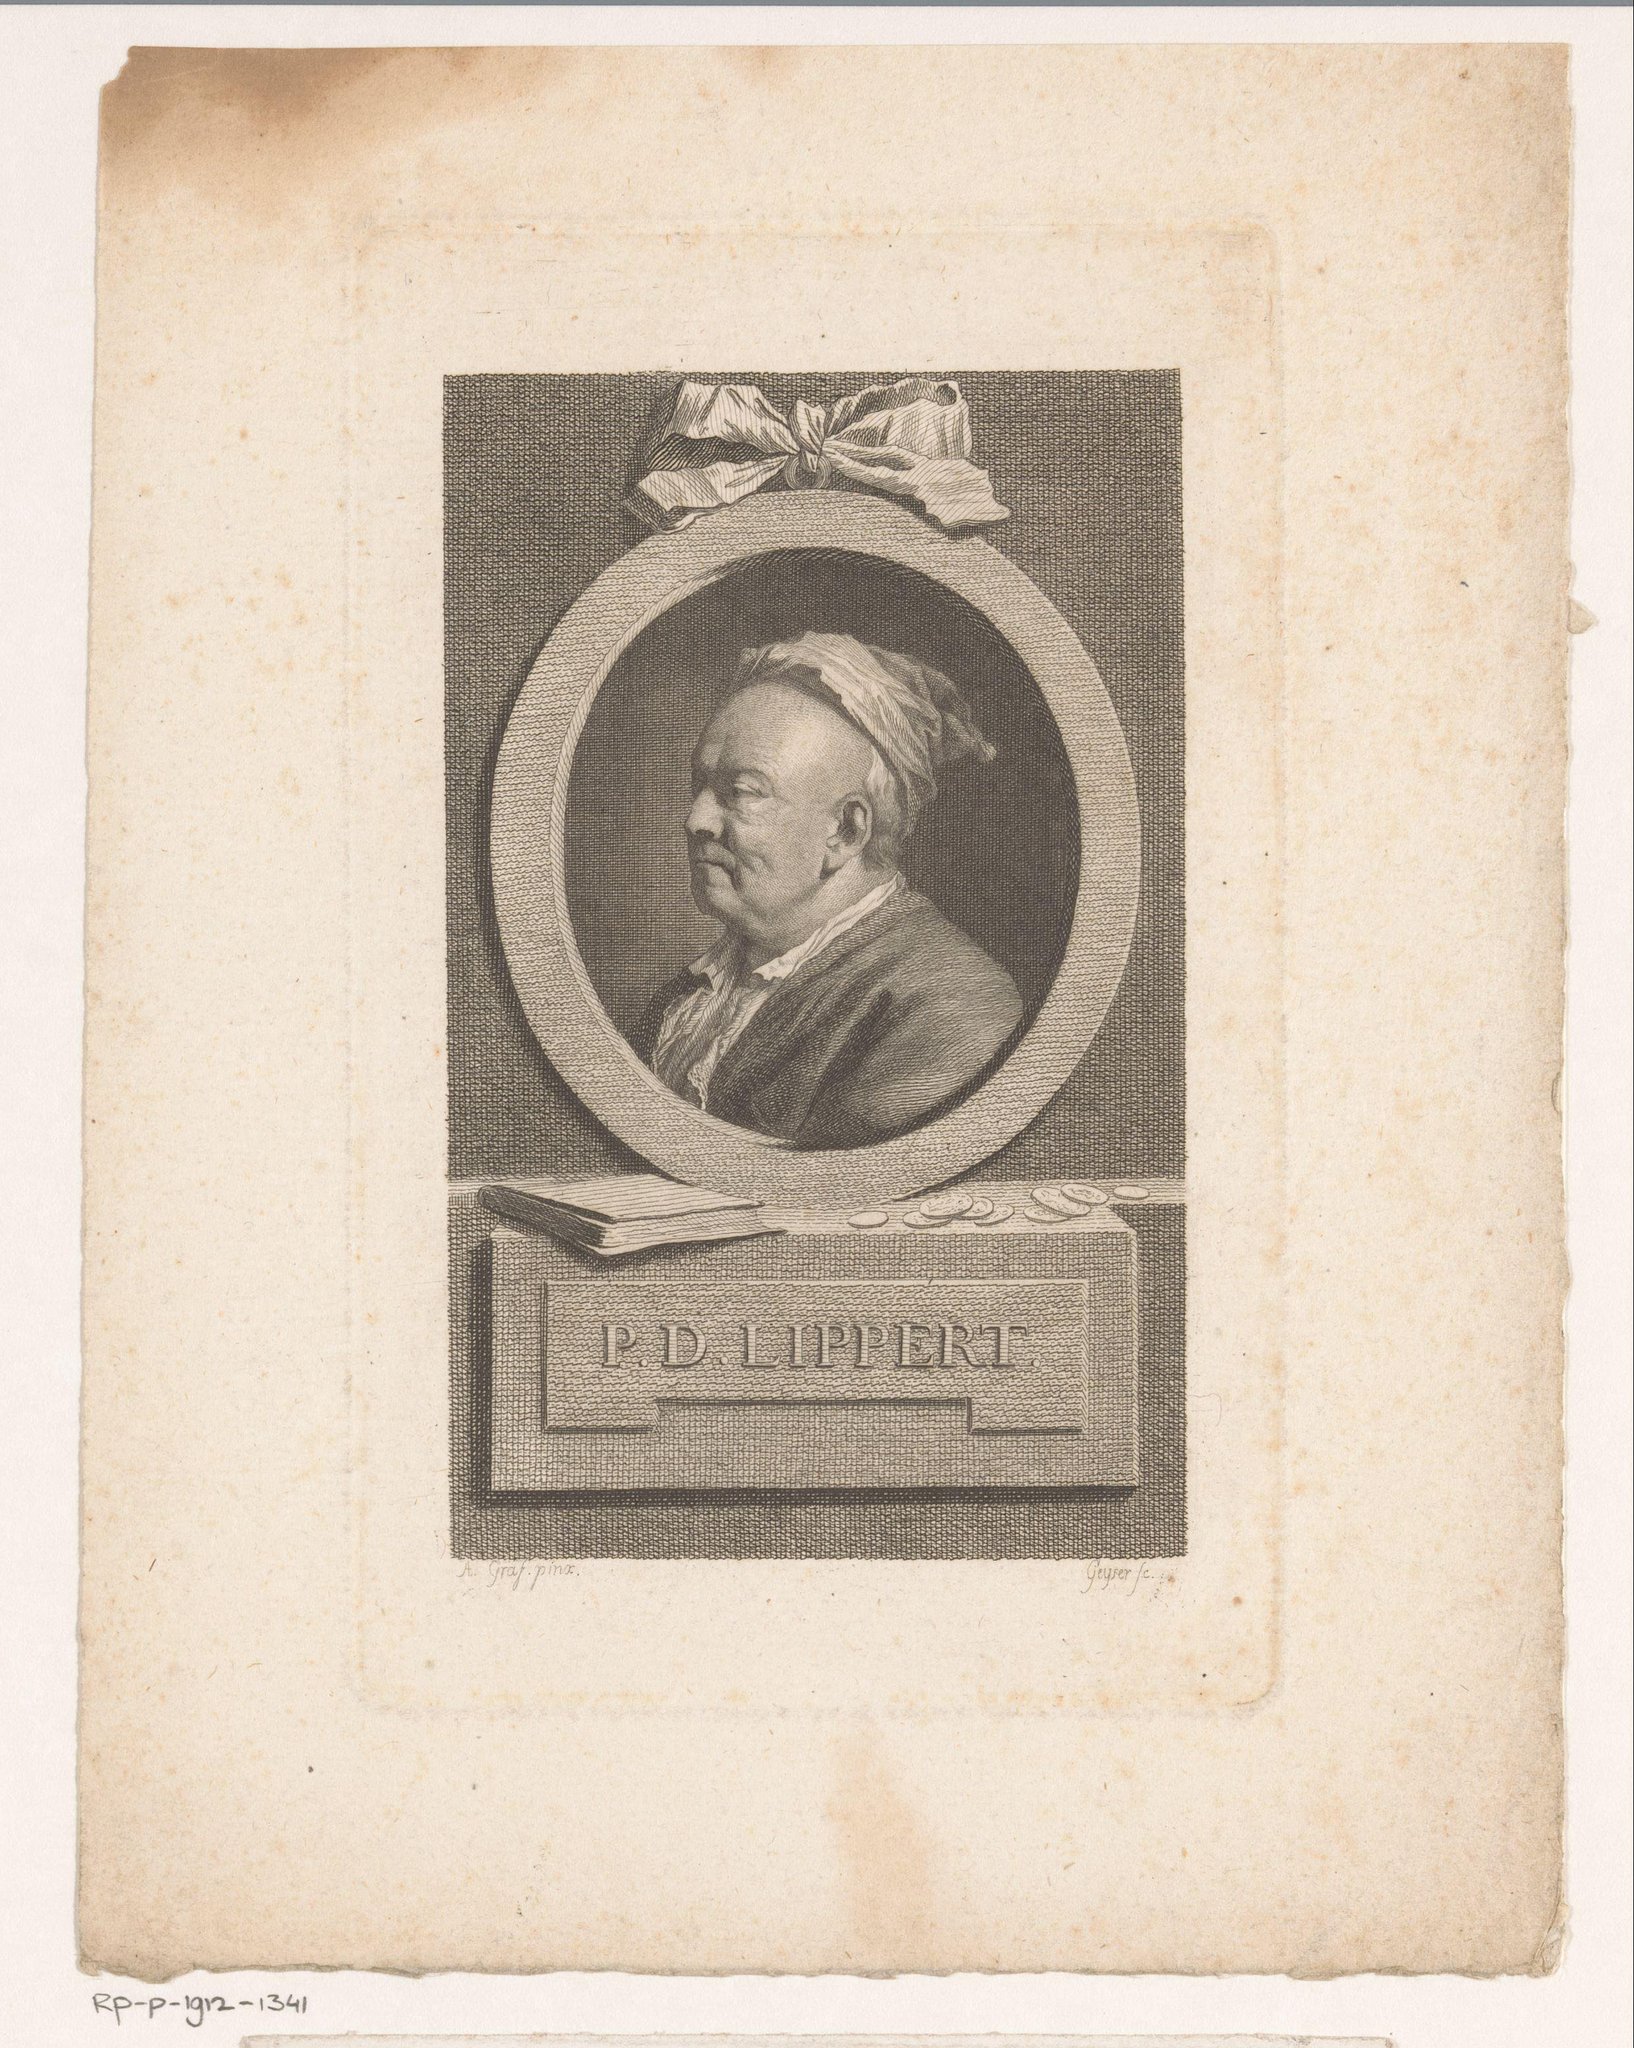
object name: print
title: Portret van Philipp Daniel Lippert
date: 1752-1803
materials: paper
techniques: engraving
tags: philip daniël lippert, history and archaeology, historical persons, coin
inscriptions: collector's mark: Lugt 2228